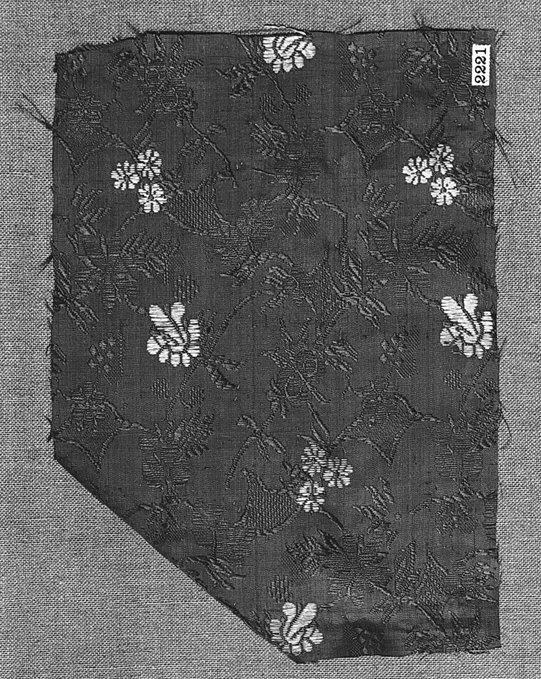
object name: piece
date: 1701-1800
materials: silk